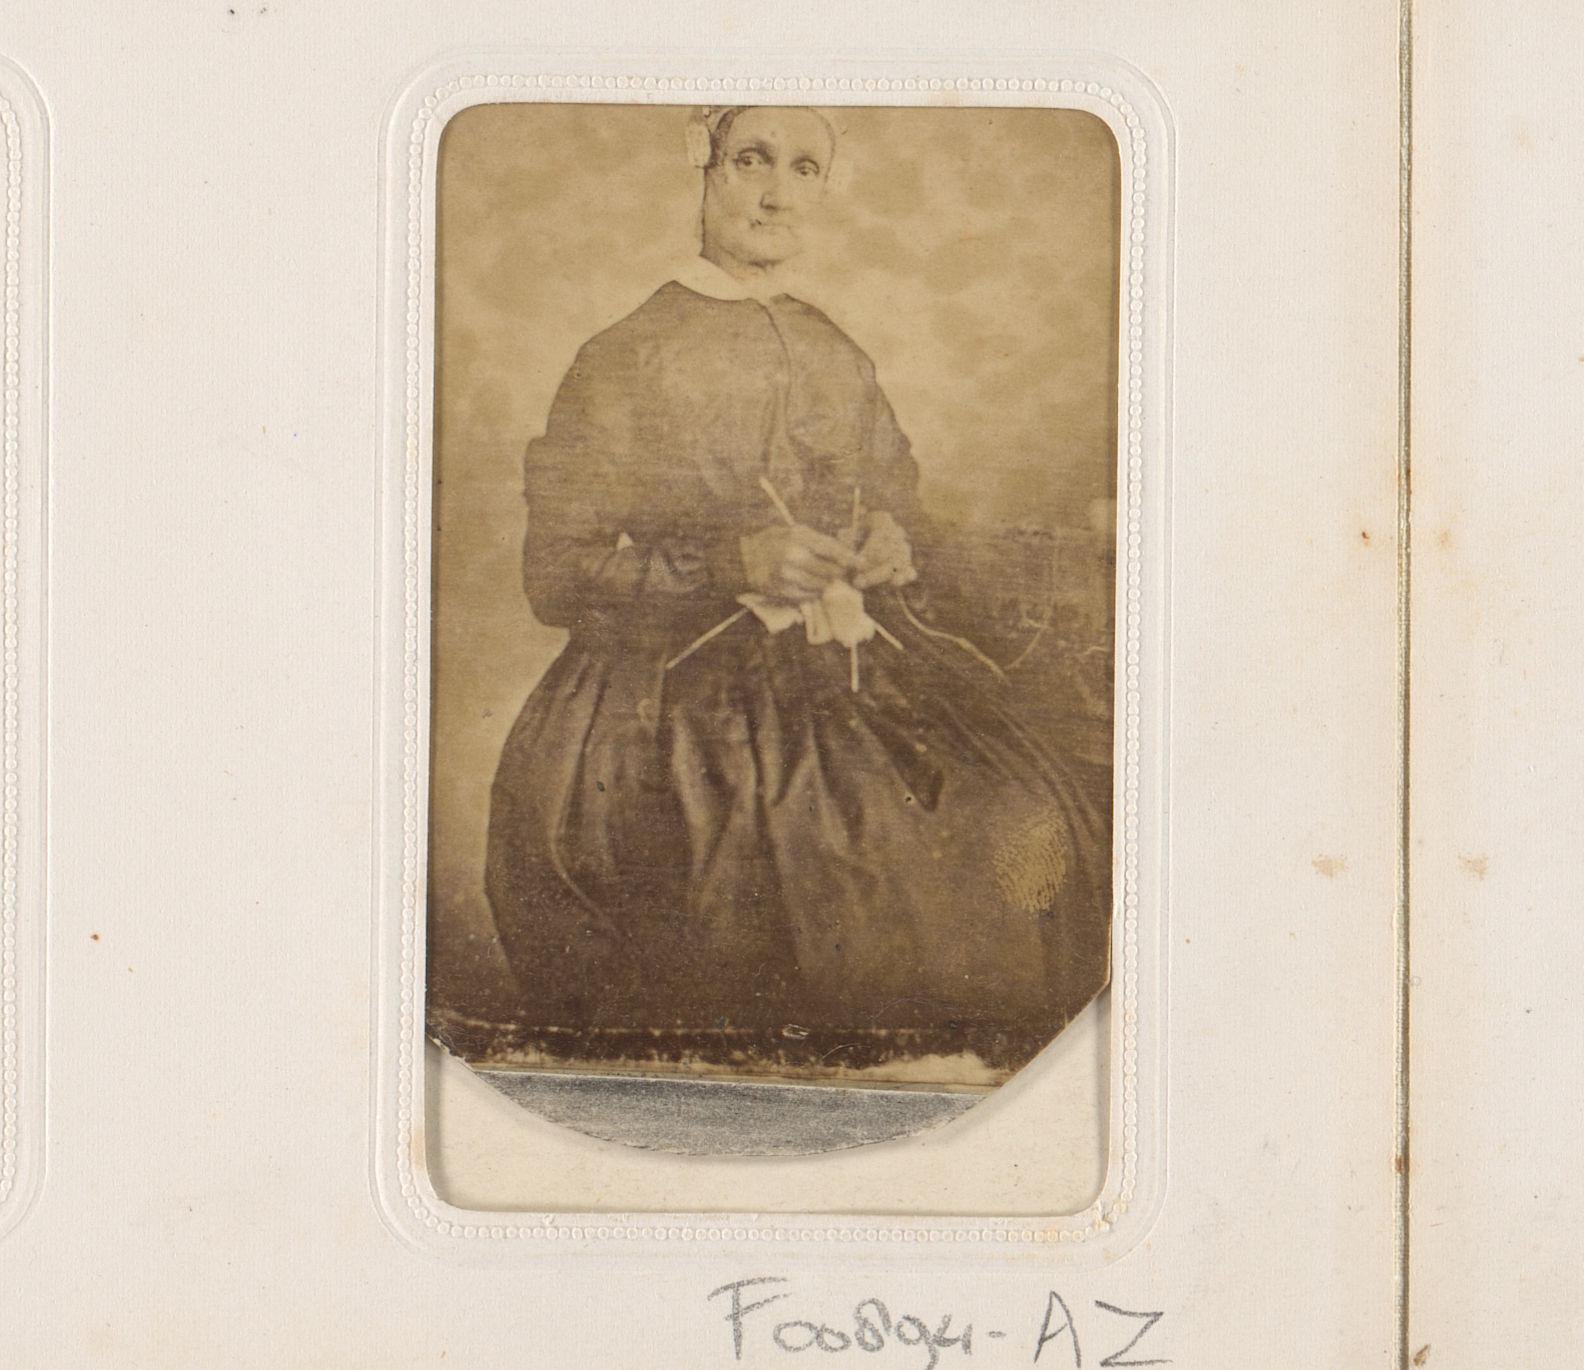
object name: photograph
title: Portret van een breiende Lijsje van Vleuten in Zaanse klederdracht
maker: Anonymous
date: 1855-1864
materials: cardboard, photographic support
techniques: albumen print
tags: sitting figure - aa - female human figure, historical persons, folk costume, regional costume, (other forms of) needlework, e.g.: crocheting, knitting, embroidering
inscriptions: inscription: ‘Heden overleden in den ouderdom van bijna 72 jaren, (...) Lijse van Vleuten, Weduwe Jacobus Johannes Kerbert (...) Koog a/d Zaan/ 20 Januarij 1864 (...)’